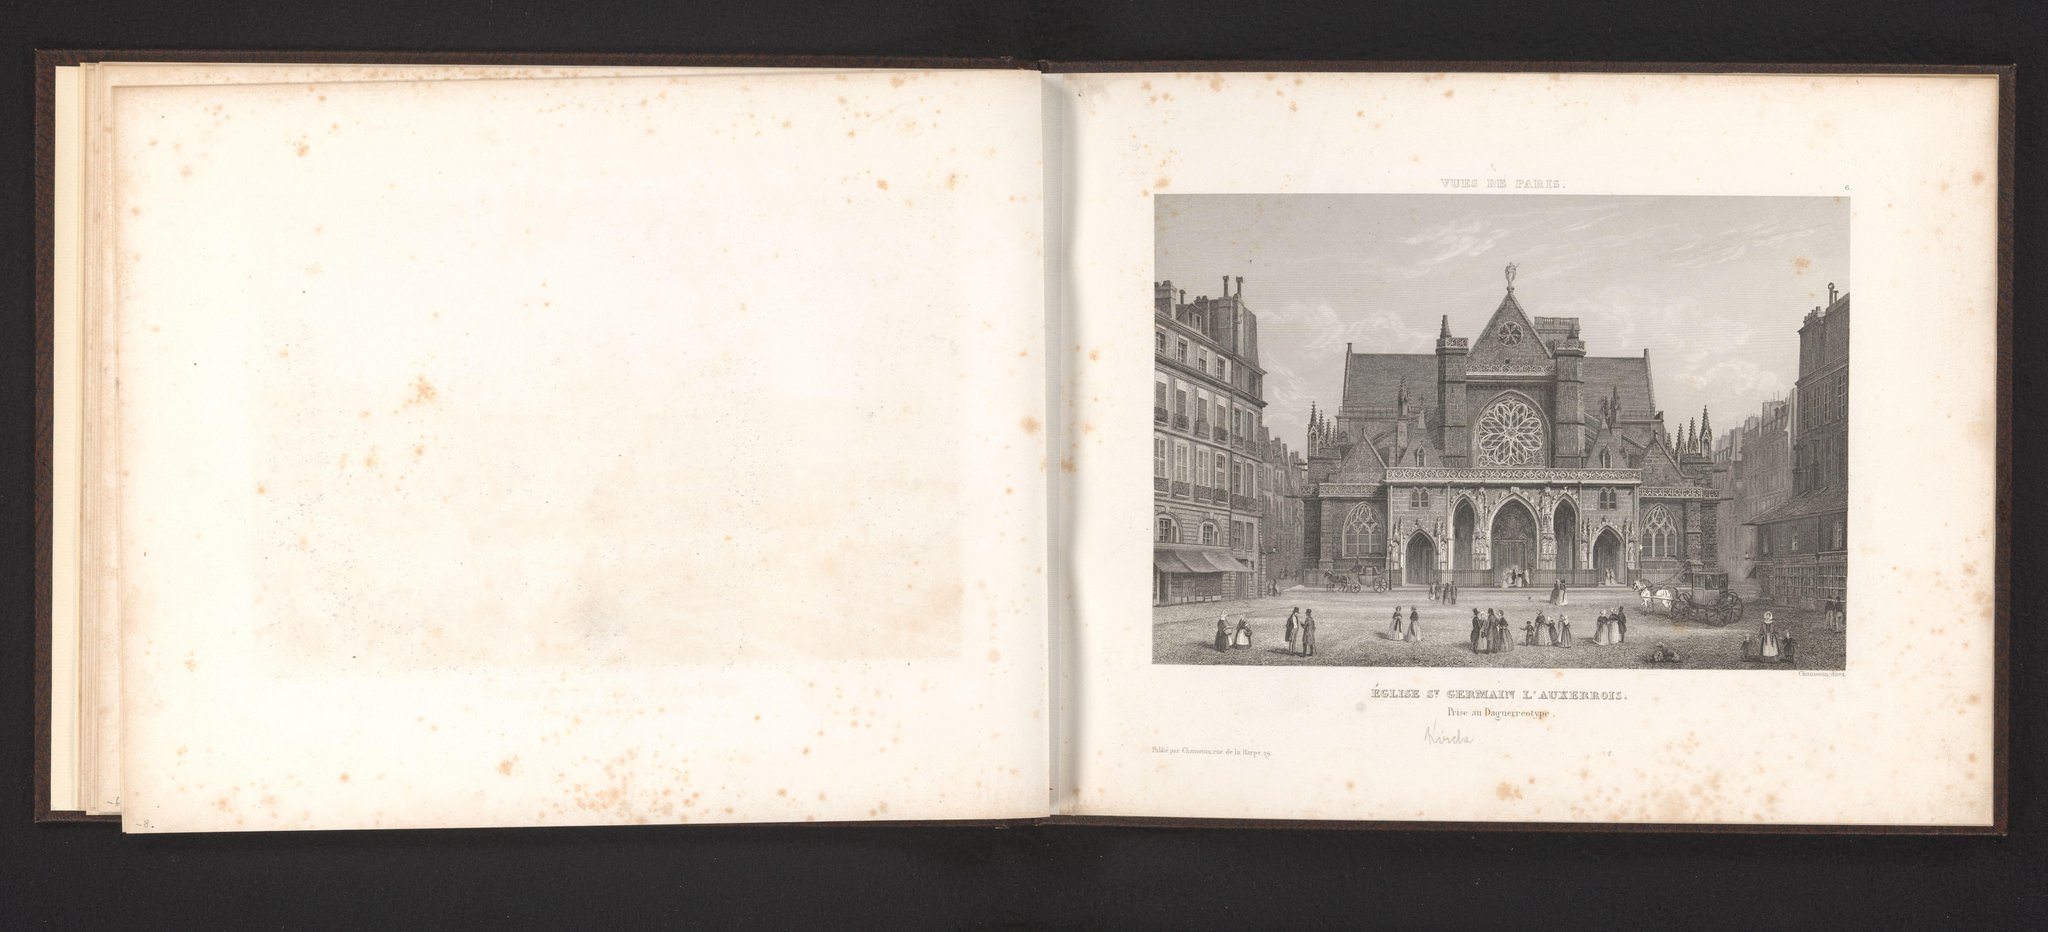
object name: page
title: Église St. Germain l'Auxerrois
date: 1845-1850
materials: paper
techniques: engraving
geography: paris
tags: church (exterior)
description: Prent op negende ongenummerde pagina na titelpagina. Prent gemaakt naar daguerreotypie.